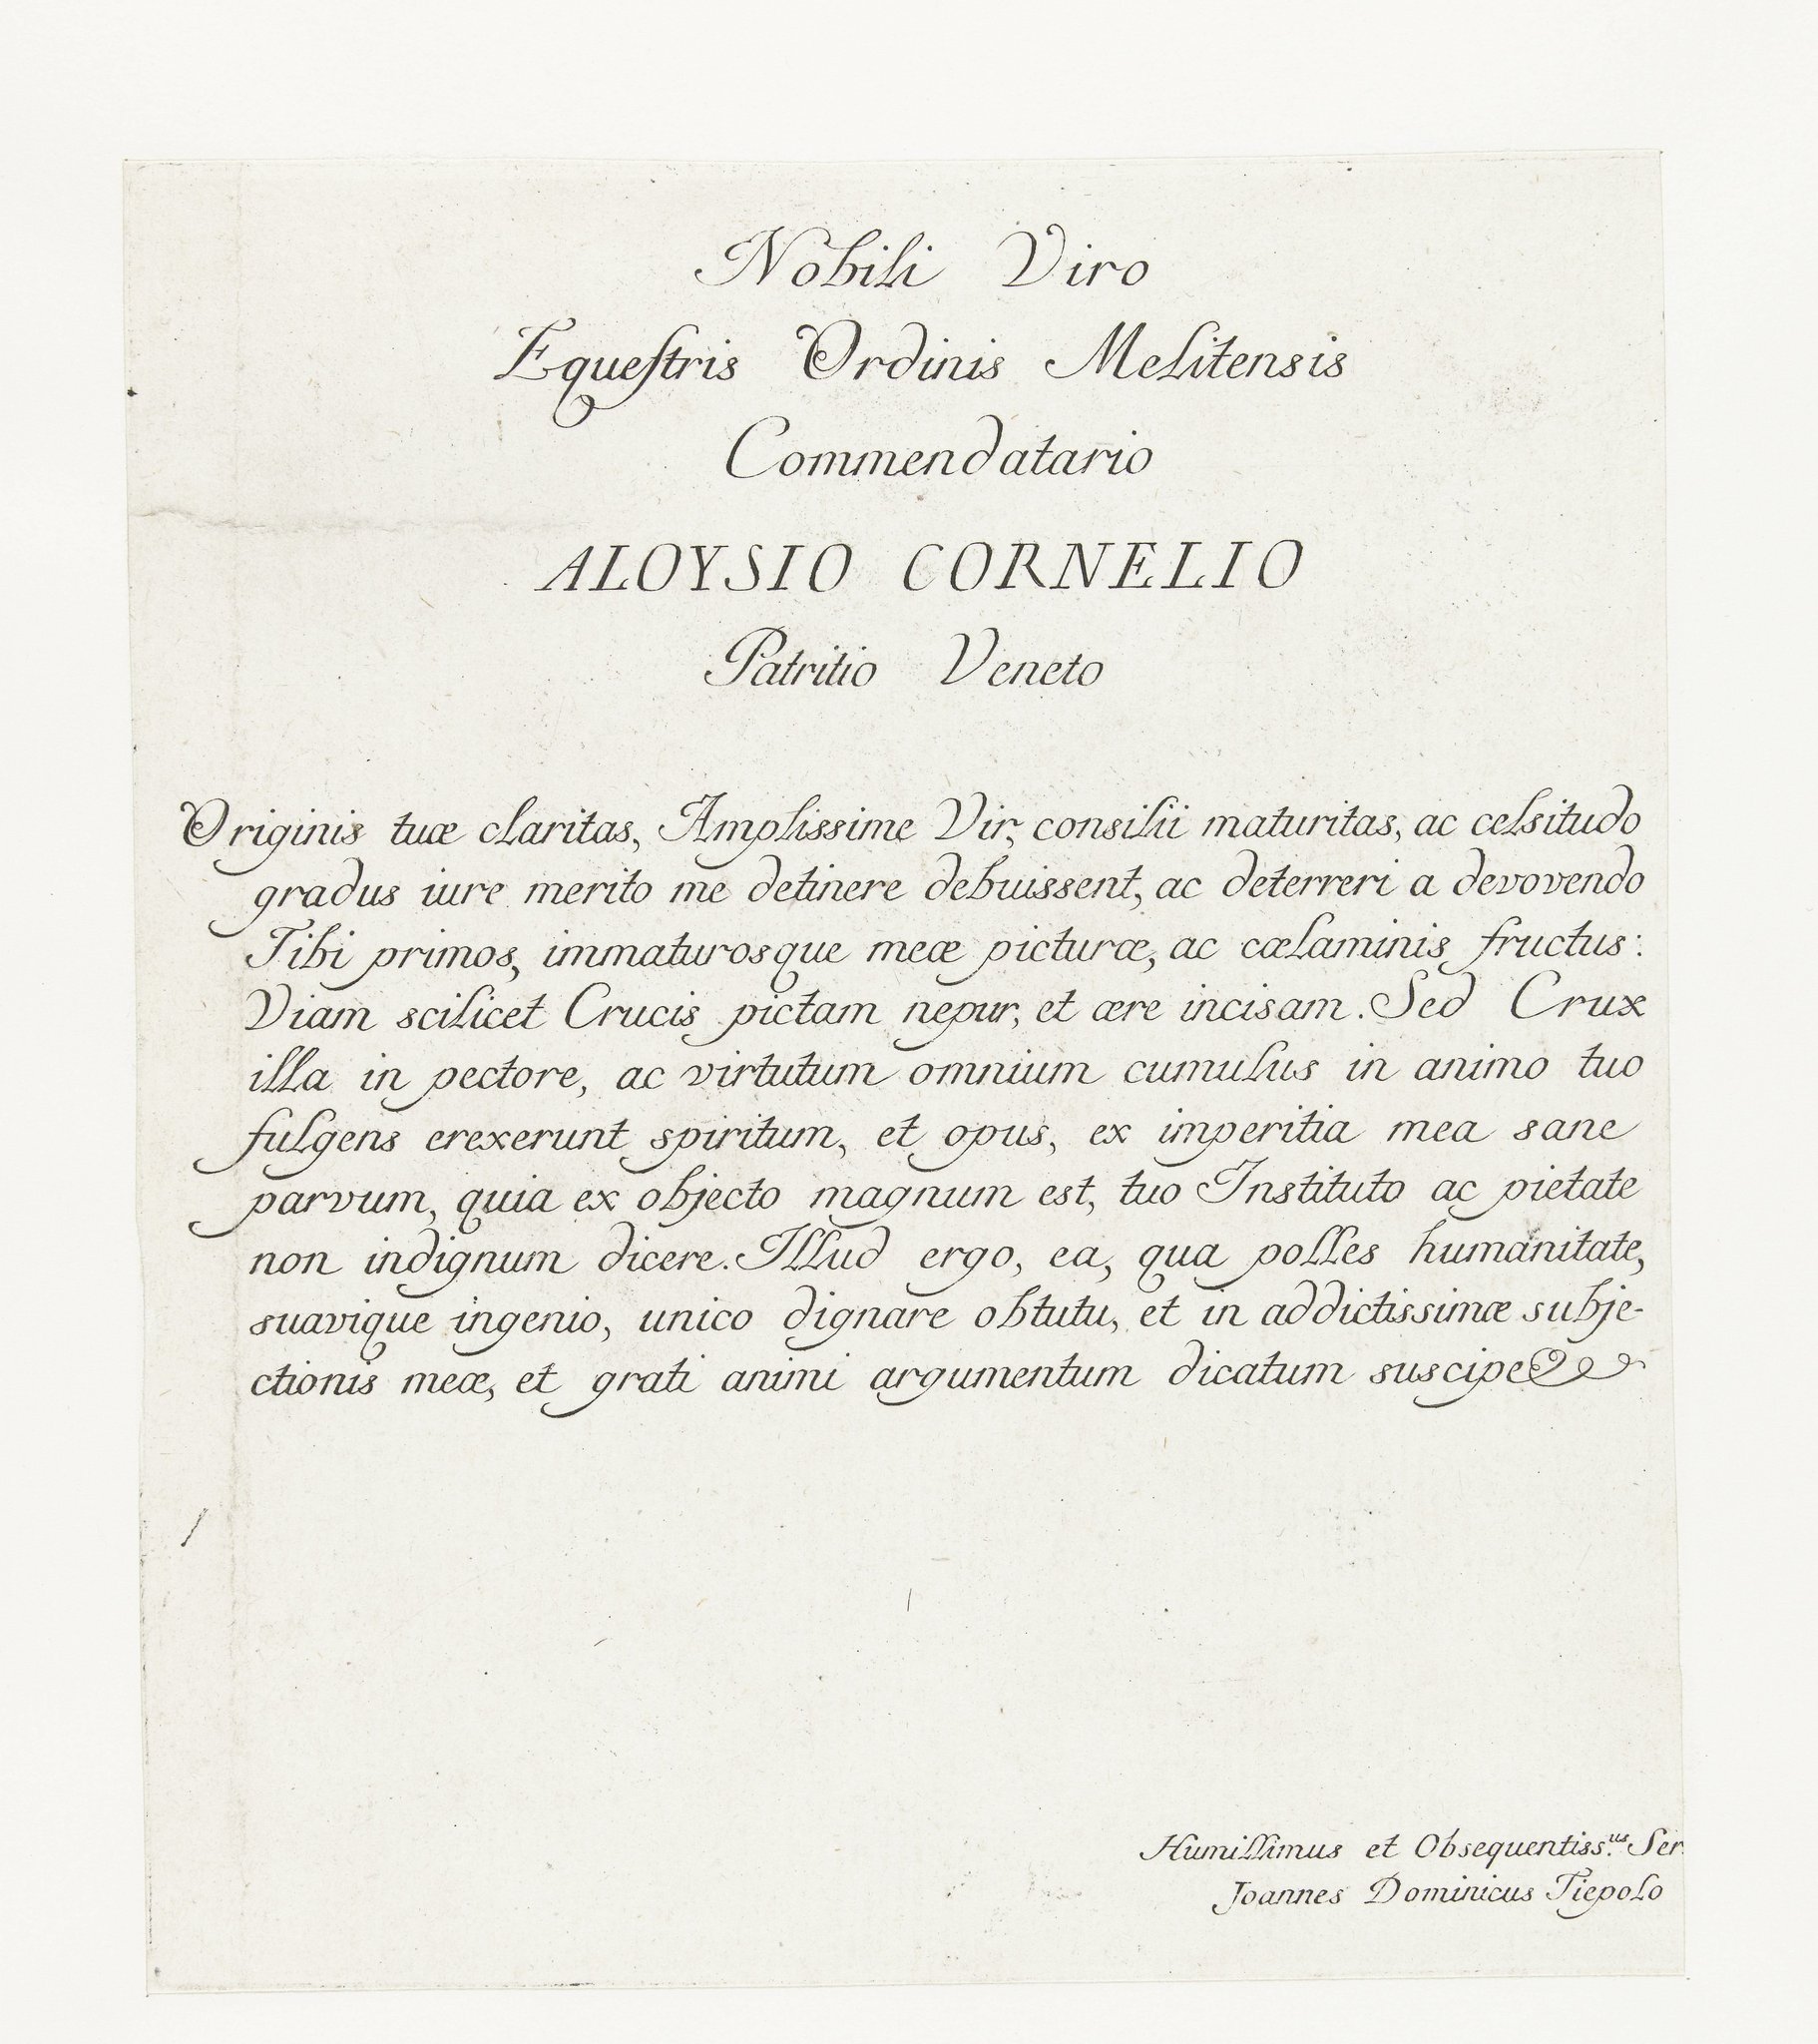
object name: print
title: Kruiswegstaties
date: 1747-1749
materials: paper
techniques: engraving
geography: venice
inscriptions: collector's mark: Lugt 2228, collector's mark: Lugt 2760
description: Opdracht voor de serie Kruiswegstaties of Via Crucis met zestien prenten.